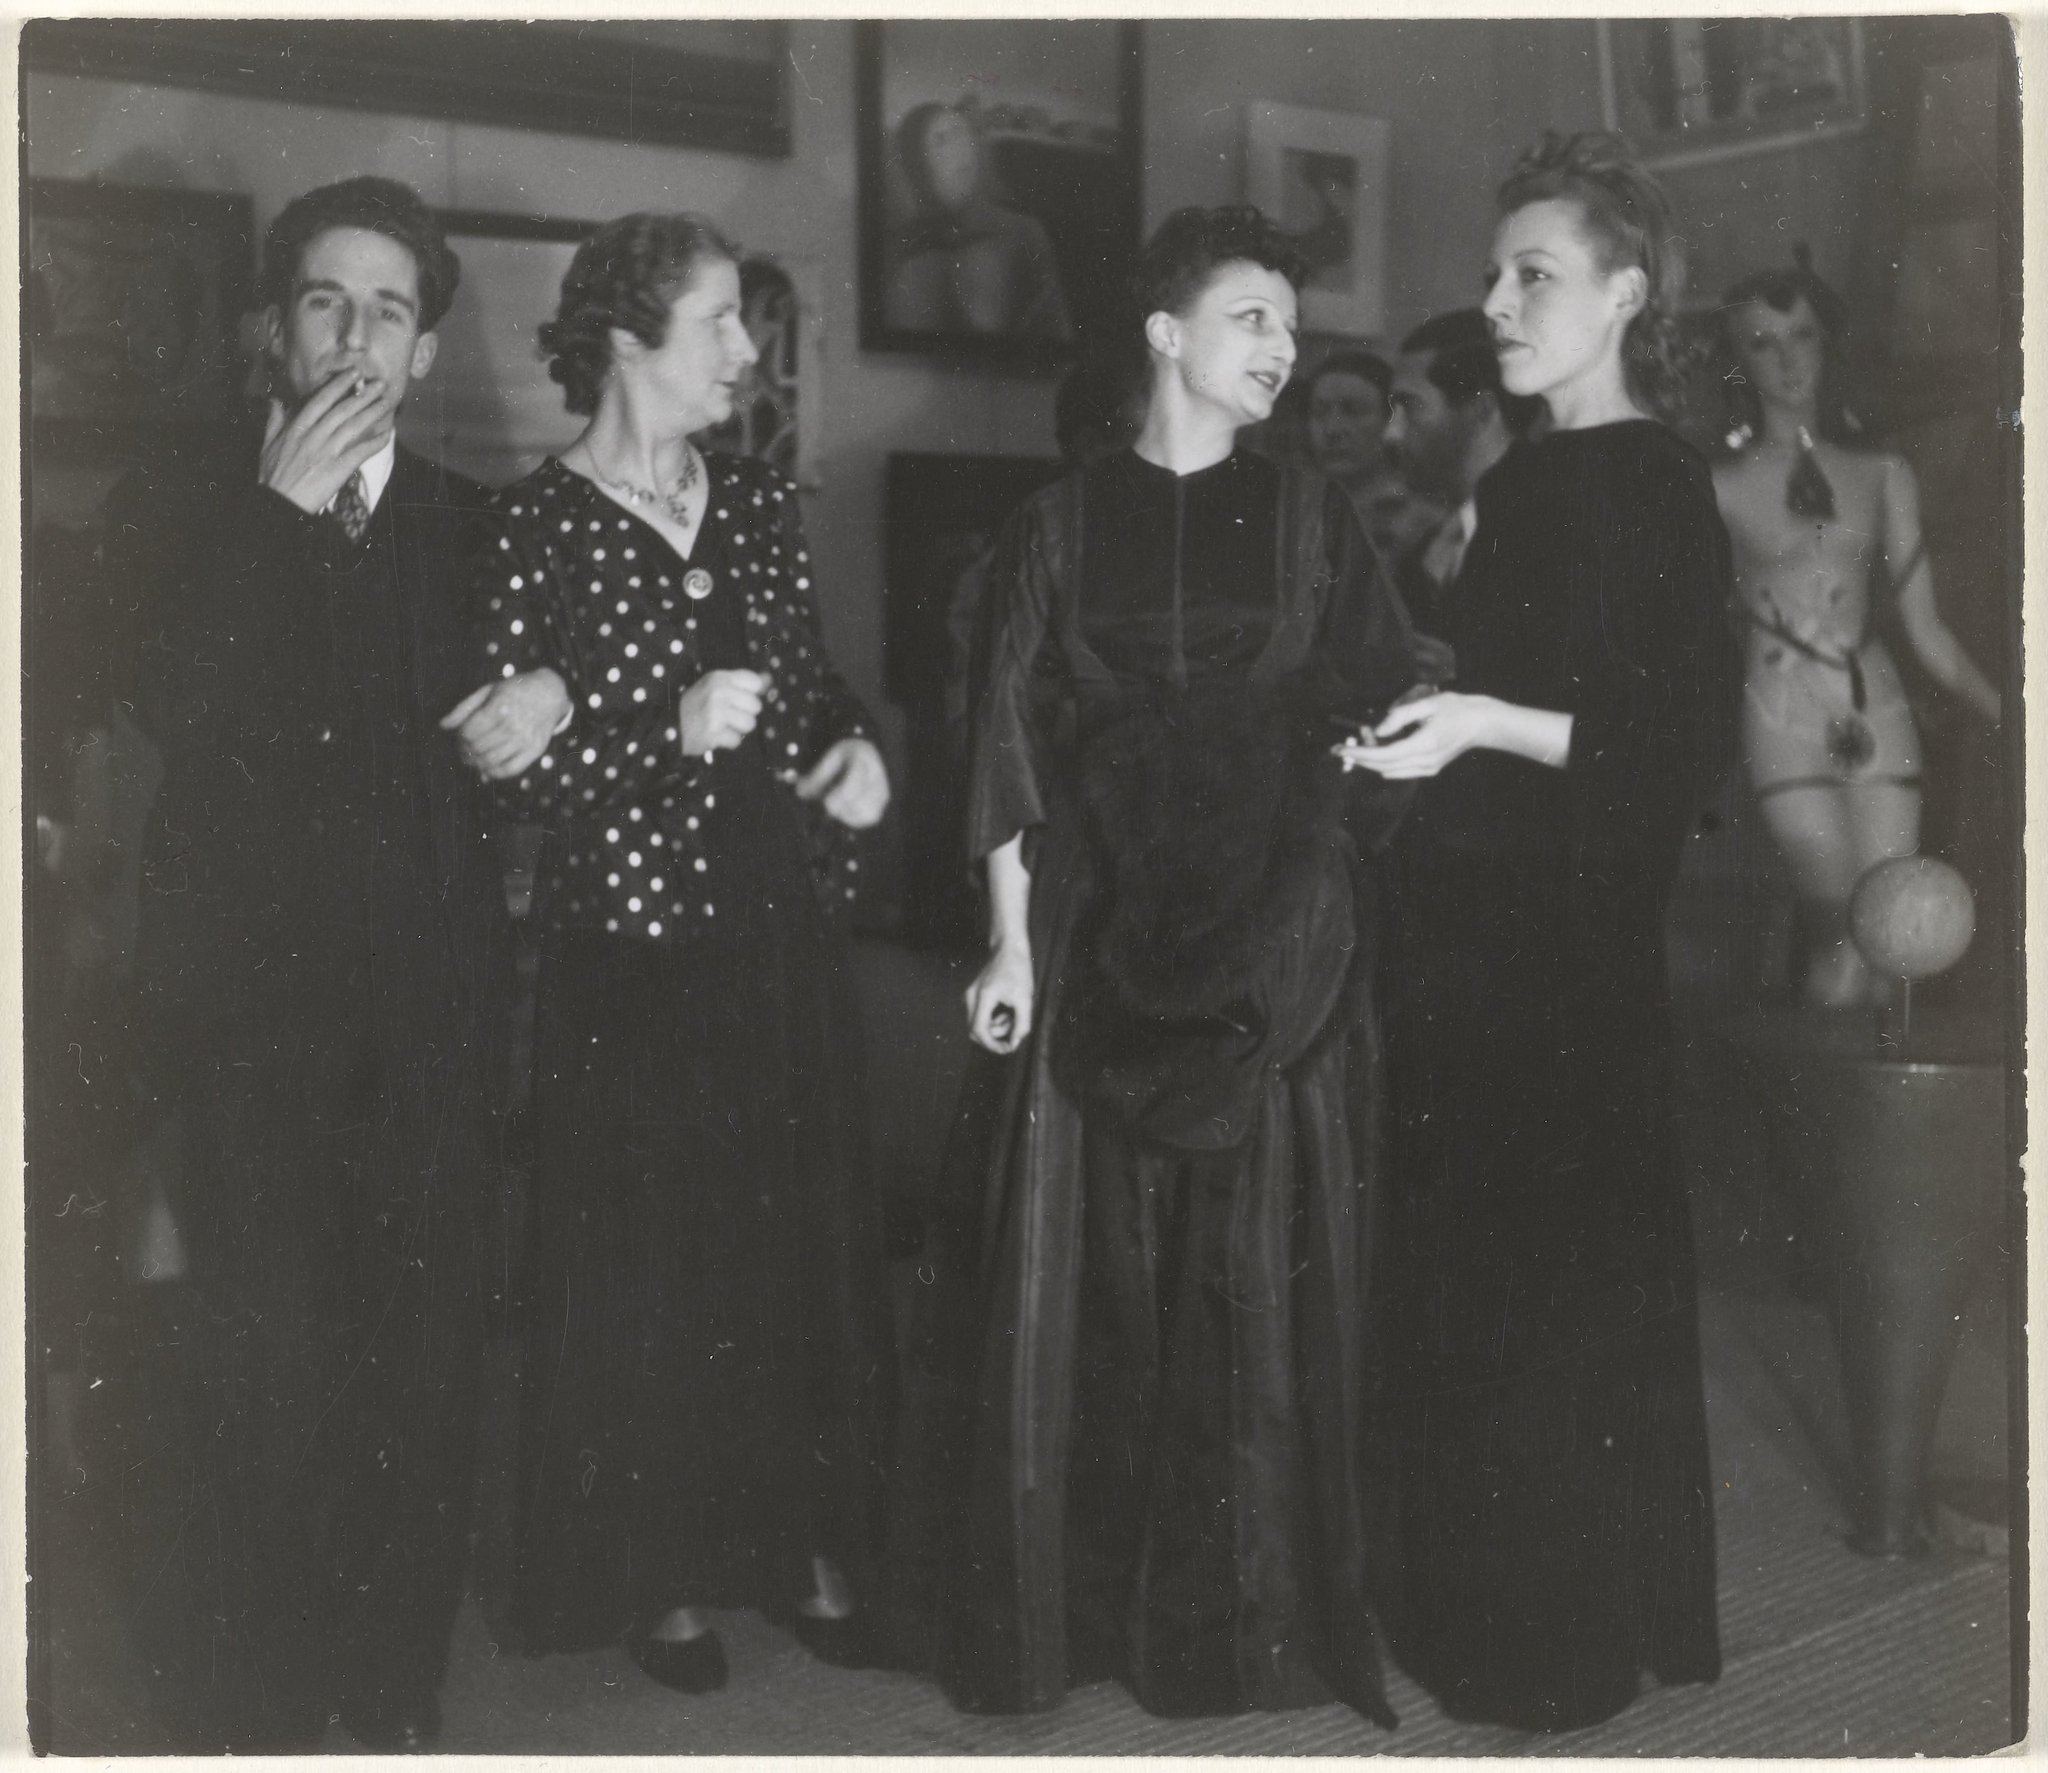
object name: photograph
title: Bezoekers van opening surrealisme-tentoonstellijg Galerie Robert Amsterdam 1938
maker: lilly samuel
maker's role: fotograaf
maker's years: 1909-1944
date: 1938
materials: photographic support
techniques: gelatin silver print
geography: amsterdam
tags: print maker, tonny kristians, amsterdam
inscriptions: stamp: ‘Galerie Robert Keizersgracht 527 Amsterdam’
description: Onderdeel van een serie betreffende een reizende tentoonstelling "Exposition Internationale du Surréalisme", in galerie Robert te Amsterdam